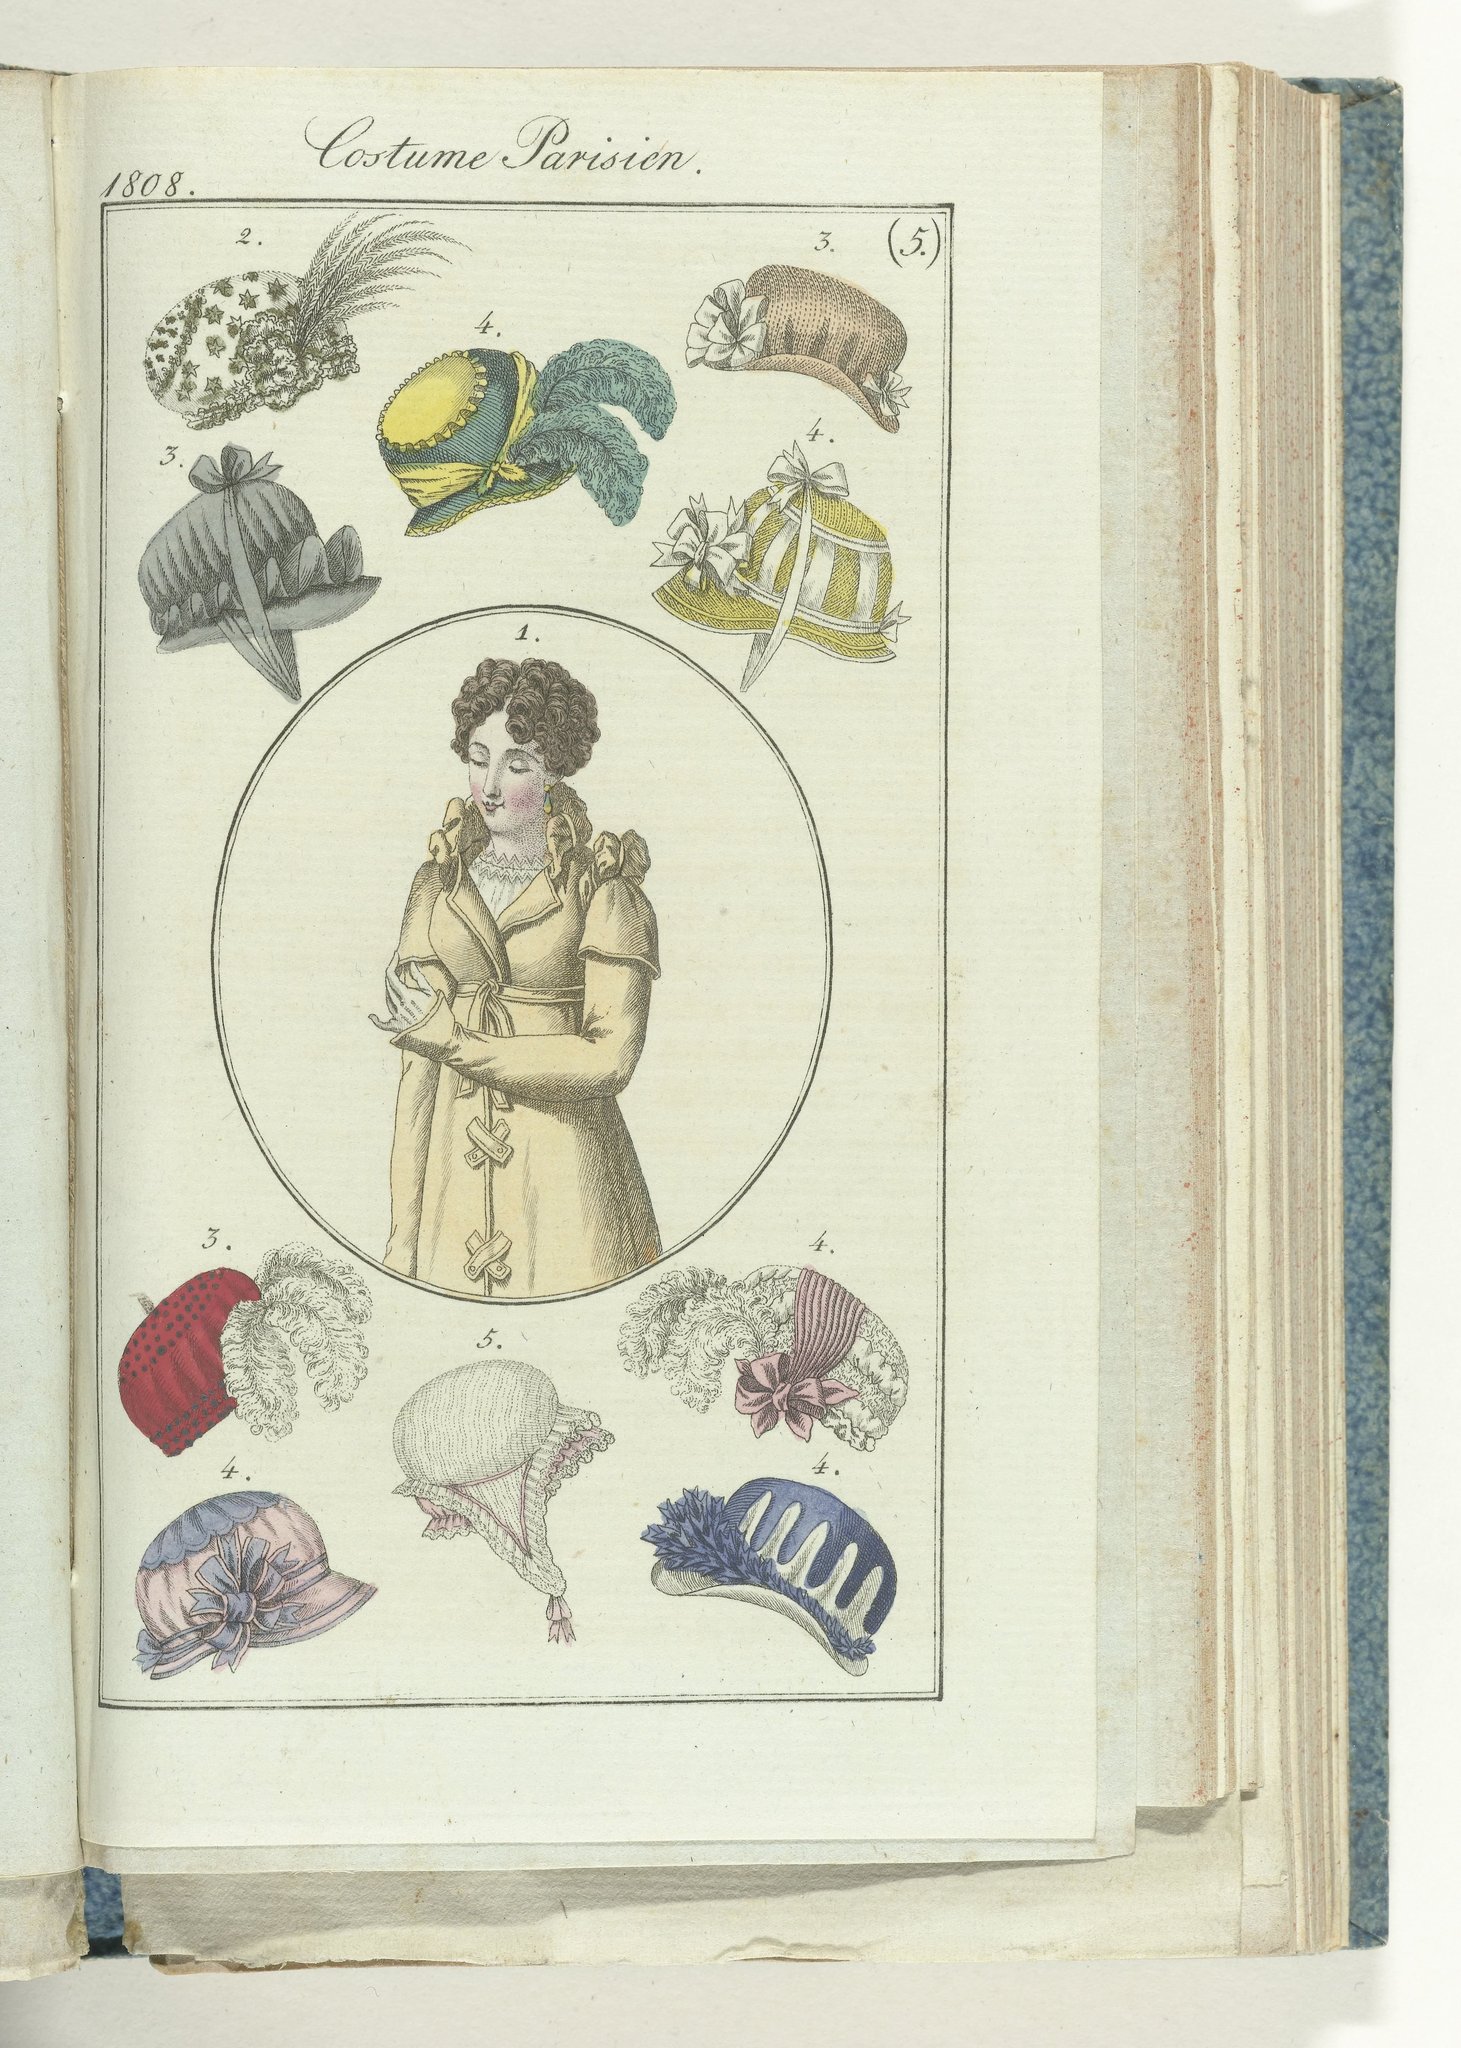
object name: magazine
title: Journal des Dames et des Modes, editie Frankfurt 1 Février 1808, Costume Parisien (5)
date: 1808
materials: paper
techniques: engraving, hand coloring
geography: frankfurt am main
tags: head-gear: toque (+ women's clothes), dress, gown: redingote (+ women's clothes), head-gear (cornette) (+ women's clothes), styles of hairdress - aa - ~ women, fashion plates, head-gear: hat (+ women's clothes), head-gear: hat (+ feathers used for clothes)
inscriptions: title: ‘Costume Parisien.’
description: Vrouwenfiguurtje in ovaal waarom heen tien modellen van hoeden. De begeleidende tekst ( p. 126) vermeldt: Fig. 1: Krullend haar. Oorbellen en palmier agathisé. Redingote van laken met boordsel van satijn. Fig. 2: Toque van levantine, met kleine metalen plaatjes. Fig. 3: Hoeden en toques van fluweel. Fig. 4: Hoeden en toques van fluweel en satijn. Fig. 5: Cornette van 'gaze filet'. De prent maakt deel uit van het modetijdschrift Journal des Dames et des Modes, uitgegeven in Frankfurt als kopie van de Franse editie van Pierre de la Mésangère, (1798-1848).